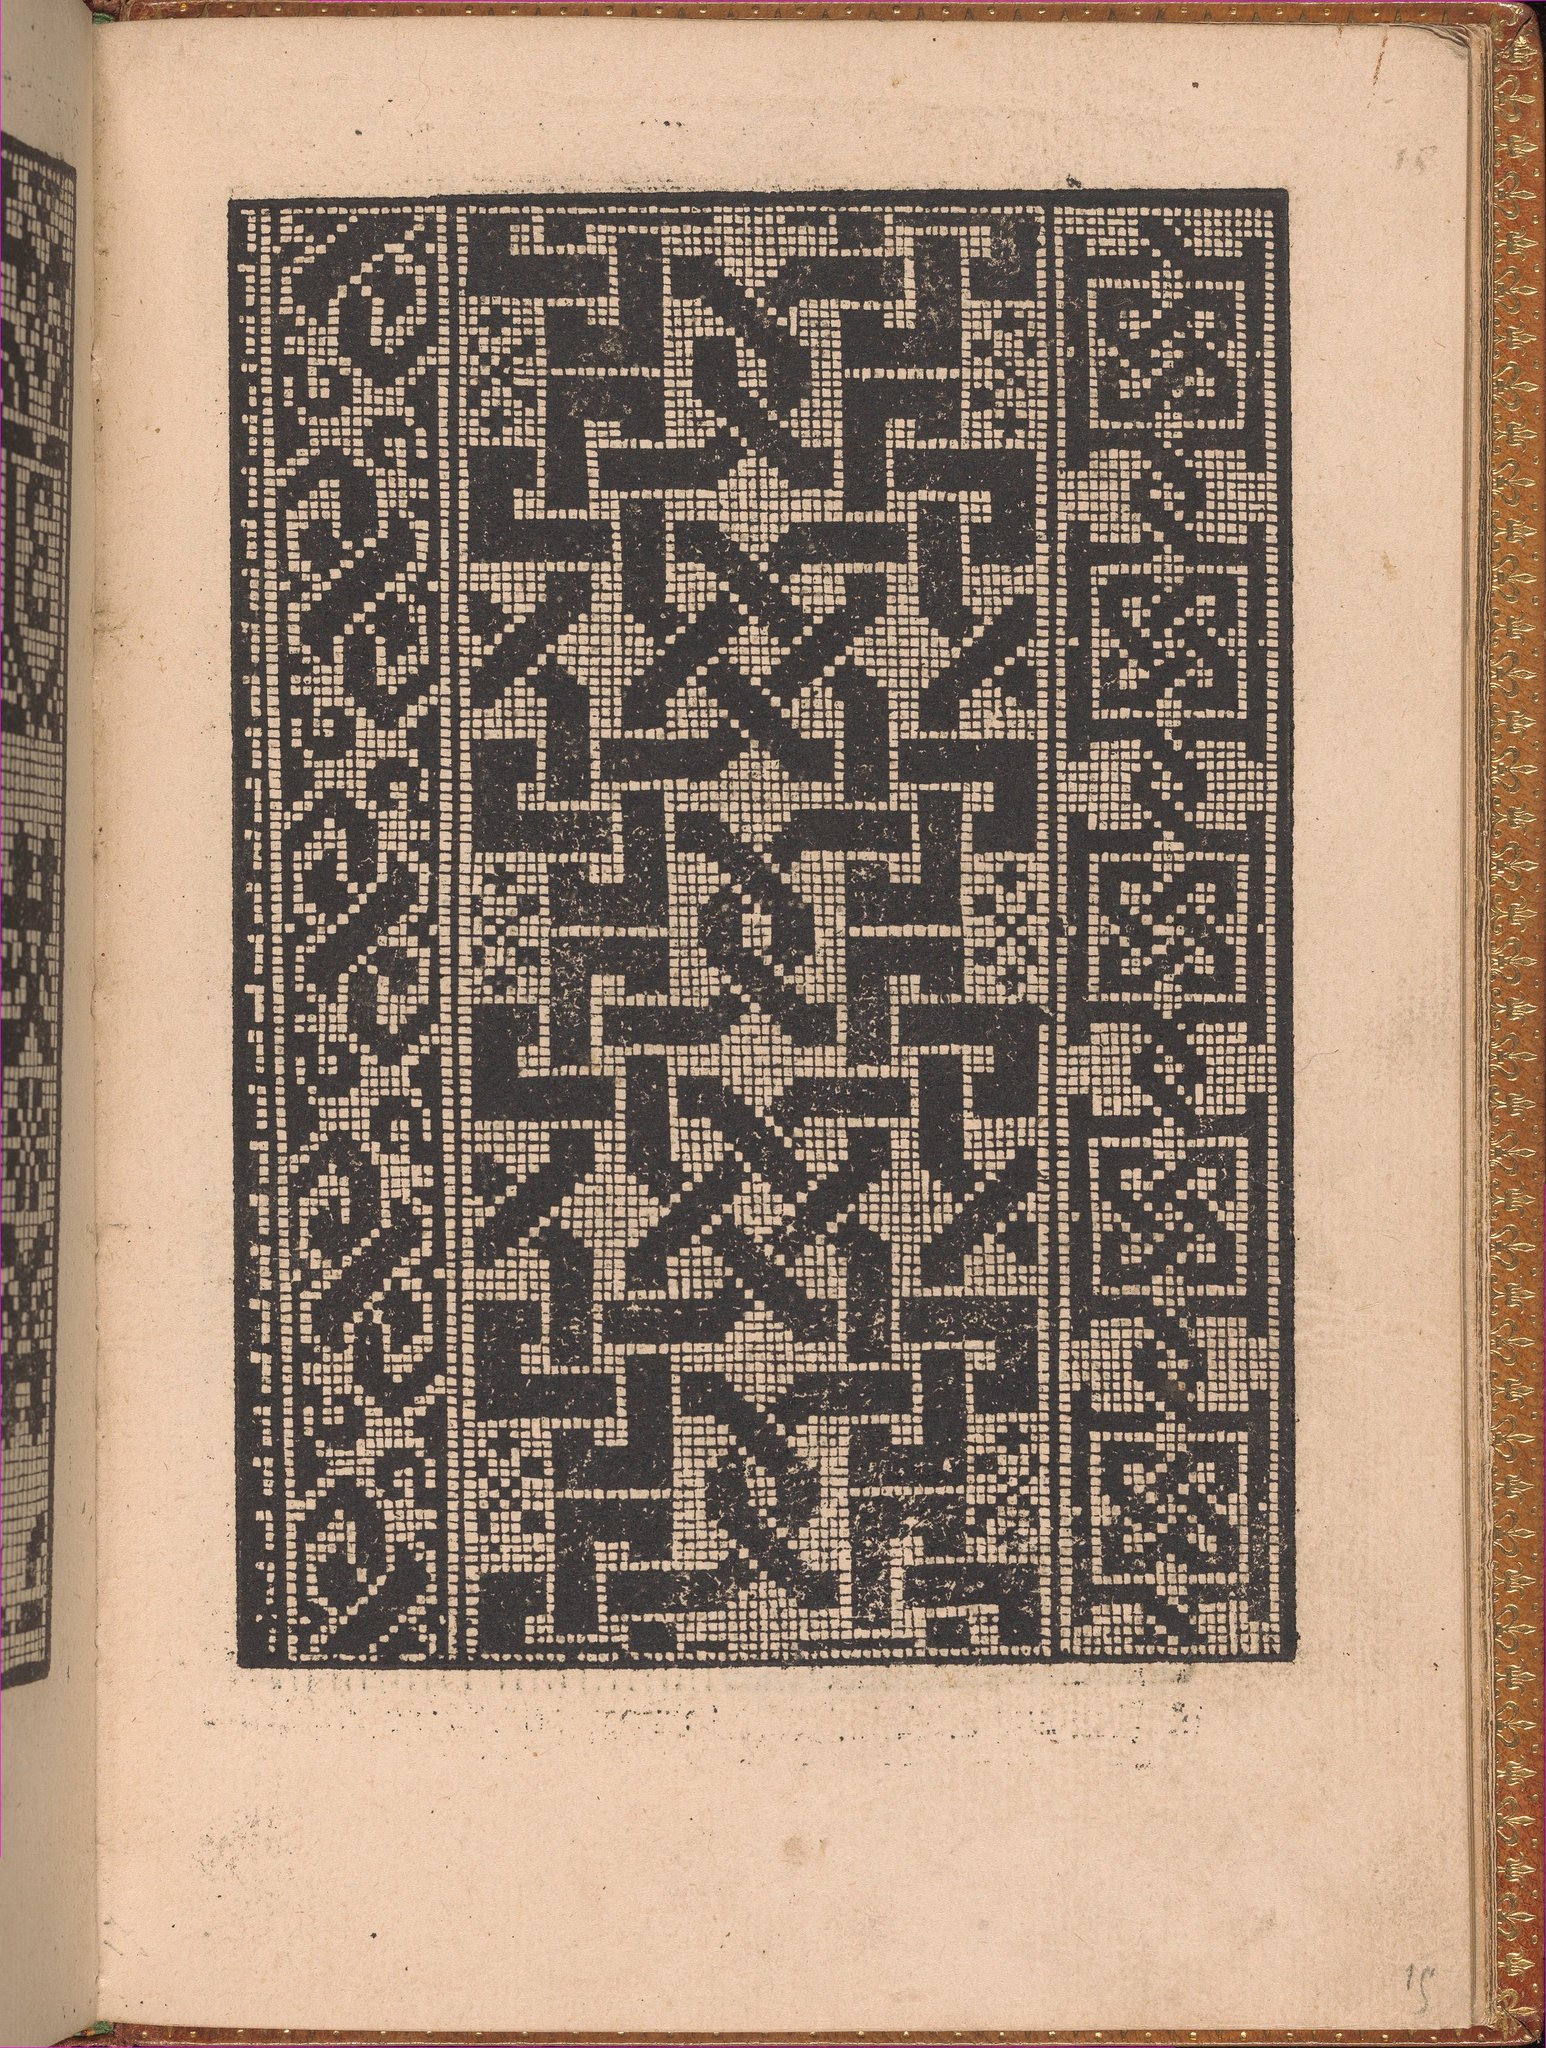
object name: book print ornament architecture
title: Convivio delle Belle Donne, page 15 (recto)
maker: nicolò zoppino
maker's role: publisher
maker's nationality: italian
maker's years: 1478-1544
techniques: woodcut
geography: italy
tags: ornament